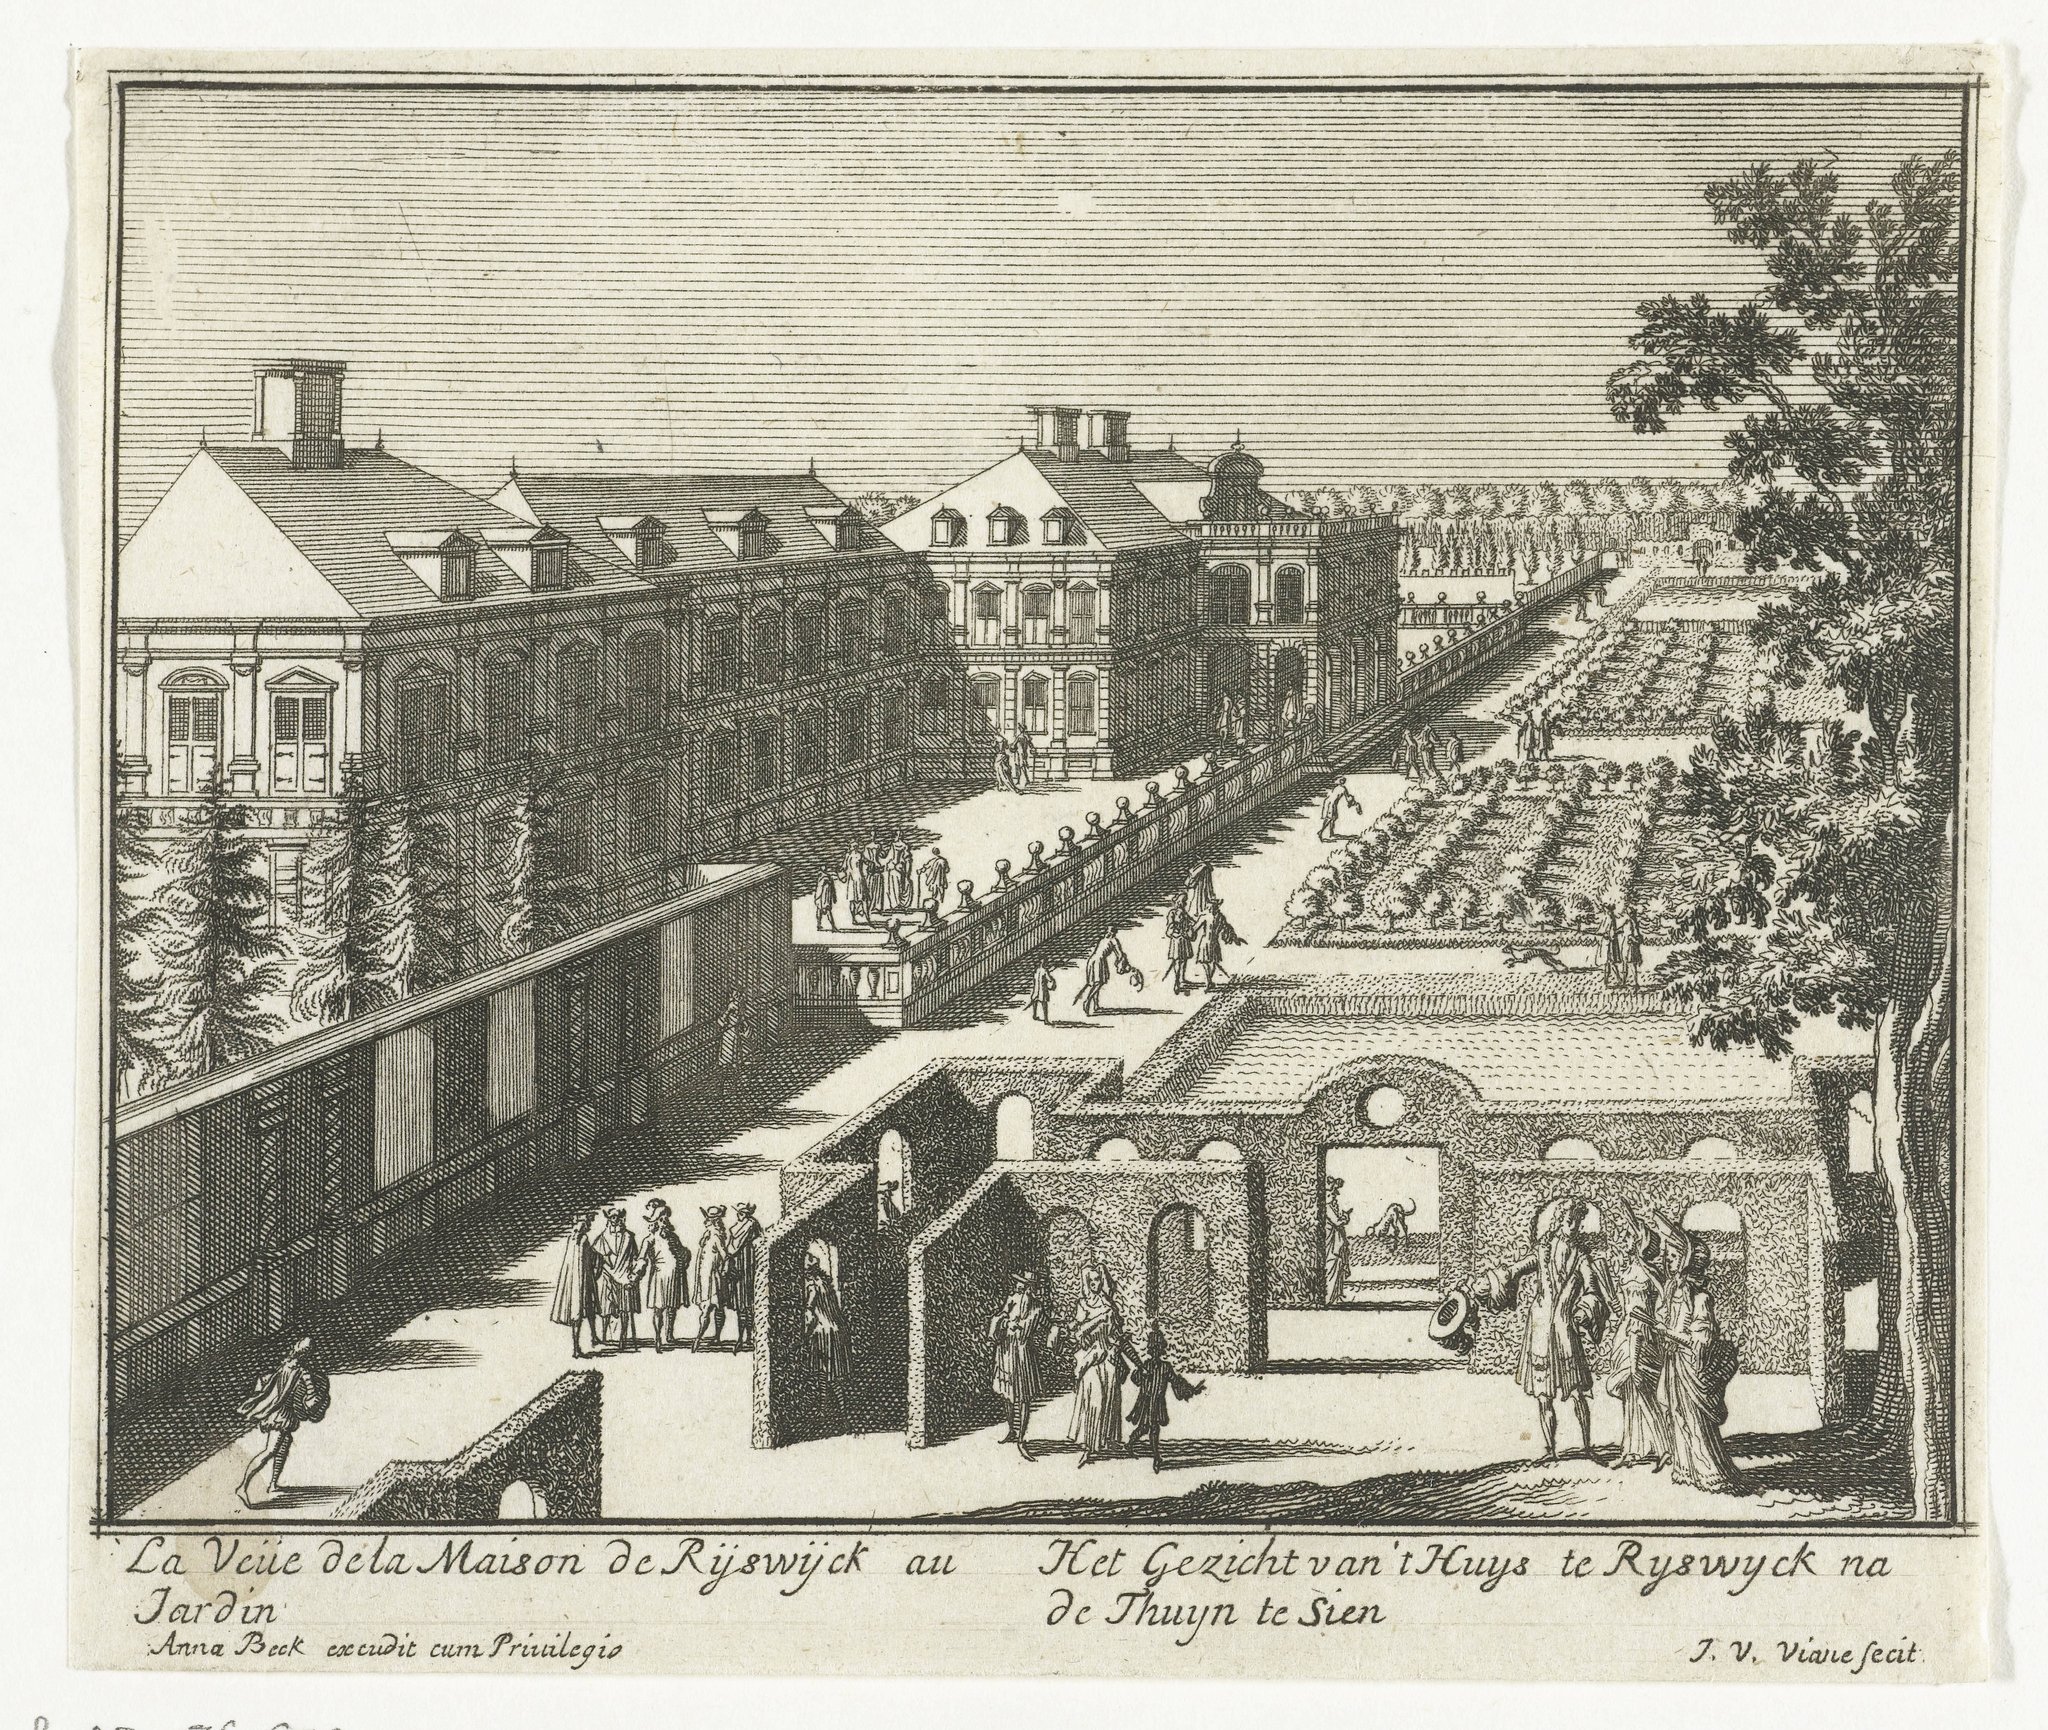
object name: print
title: Gezicht op de tuinen bij het Huis ter Nieuburch in Rijswijk, 1697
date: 1697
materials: paper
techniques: etching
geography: northern netherlands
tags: garden, palace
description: Gezicht op de tuinen bij het Huis ter Nieuburch in Rijswijk. In het onderschrift de twee titels in het Frans en Nederlands. Onderdeel (prent 16) van de serie van zestien kleinere prenten over het Huis ter Nieuburch in Rijswijk en de daar gehouden vredesonderhandelingen resulterend in de Vrede van Rijswijk gesloten op 20 september 1697.